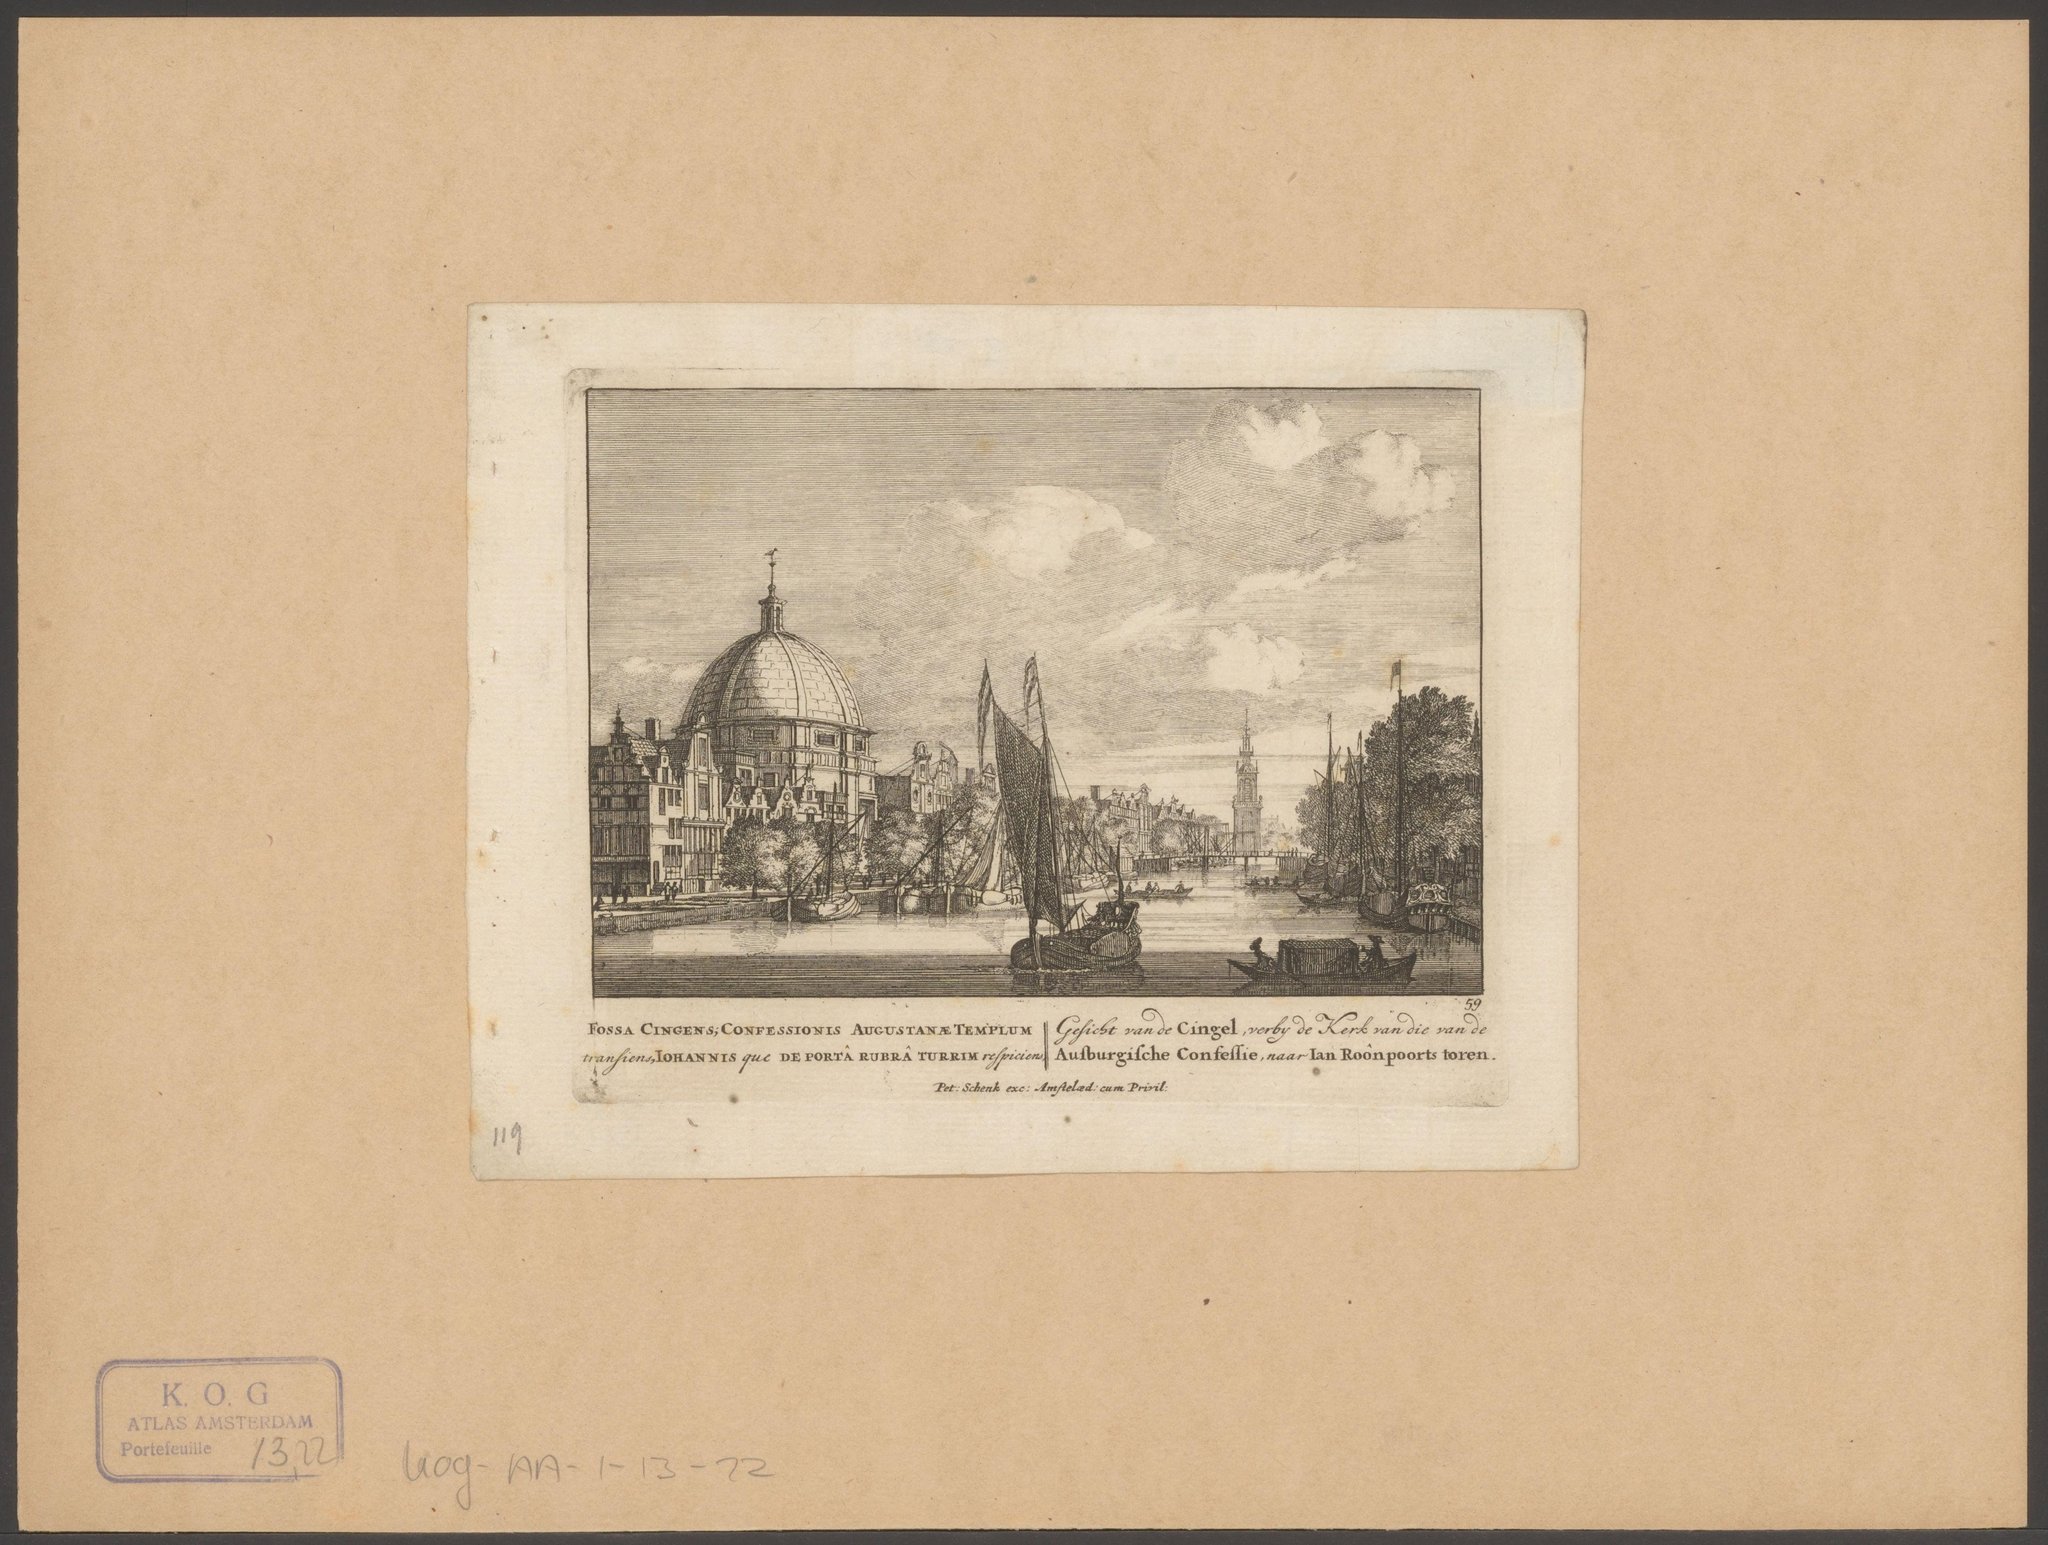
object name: print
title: Admirandorum Quadruplex Spectaculum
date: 1694-1697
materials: paper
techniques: etching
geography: amsterdam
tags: sailing-ship, sailing-boat, tower, clock tower ~ monumental adornment, city-view in general; 'veduta', canal, church (exterior), bridge in city across river, canal, etc.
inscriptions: collector's mark: ‘13,22’ Lugt 1641b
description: Prent gebruikt in: Call, Jan van. Admirandorum Quadruplex Spectaculum. Amsterdam: Pieter Schenk (I), 1700. De titelprent, opdracht en het portret van Frederik van Saksen zijn gegraveerd door Pieter Schenk (I). De overige prenten uit deze serie zijn, zoals aangegeven op de titelprent, van de hand van Jan van Call (I).